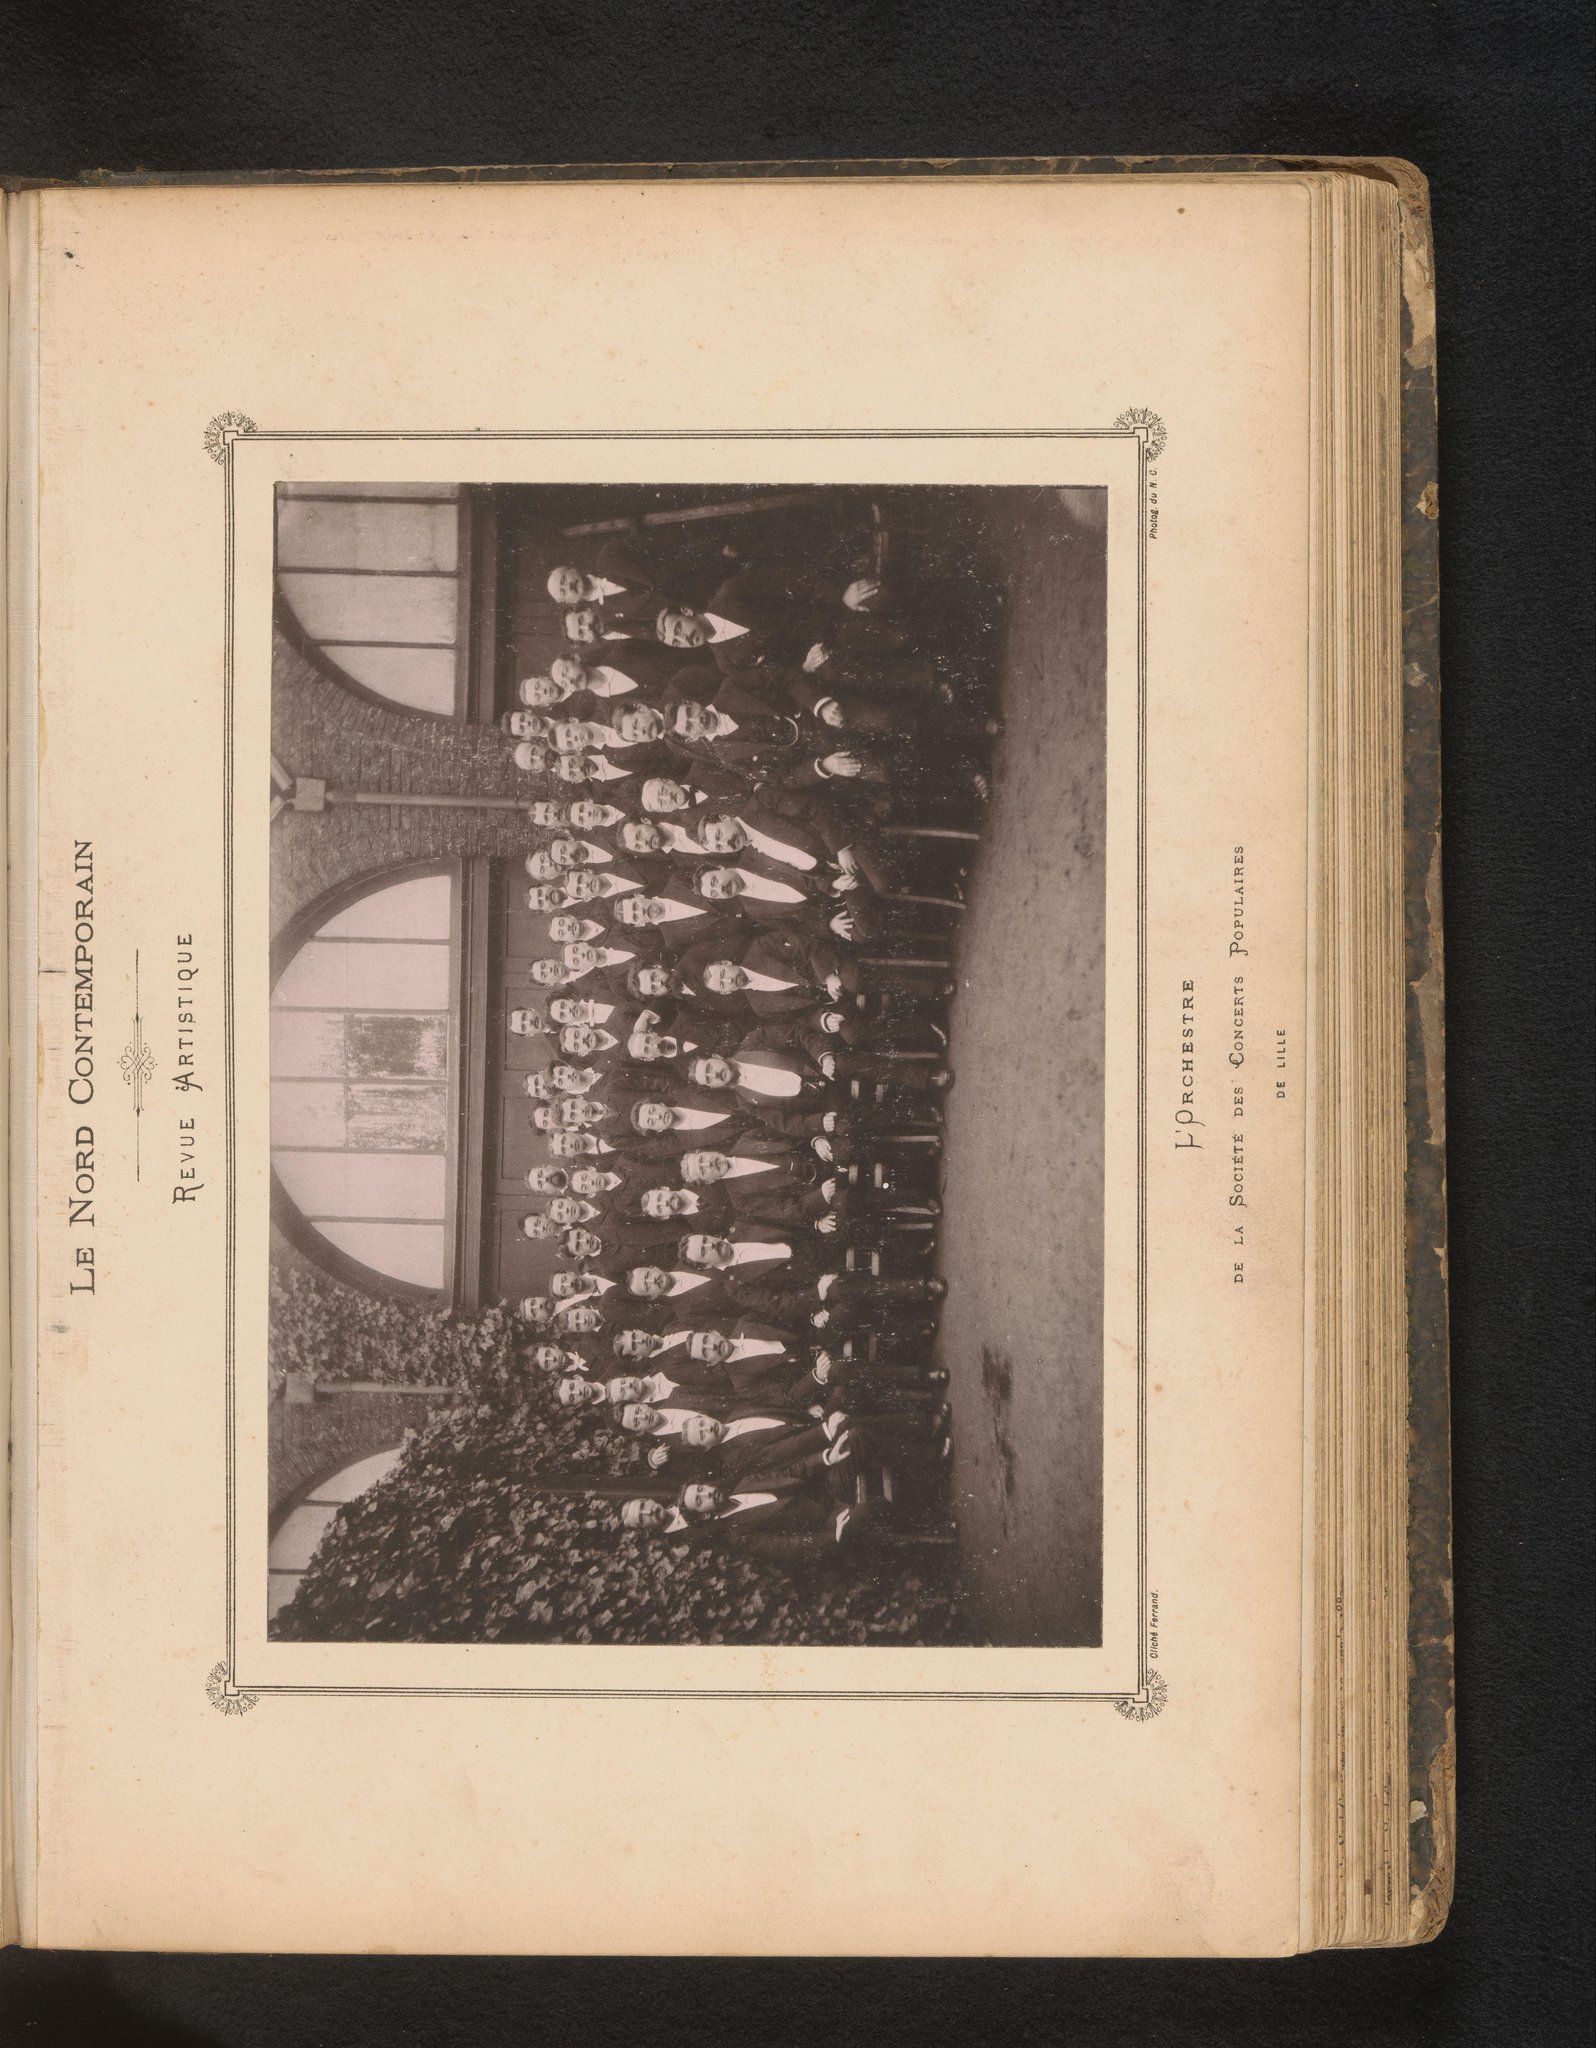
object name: page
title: Groepsportret van het orkest van de Société des Concerts Populaires in Lille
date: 1878-1883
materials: paper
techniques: photograph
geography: lille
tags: large group of musicians, orchestra, anonymous historical persons portrayed in a group, in a group-portrait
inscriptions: inscription: ‘Le Nord Contemporain/ Revue Artistique’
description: Prent op vijfde ongenummerde pagina na pagina 80.